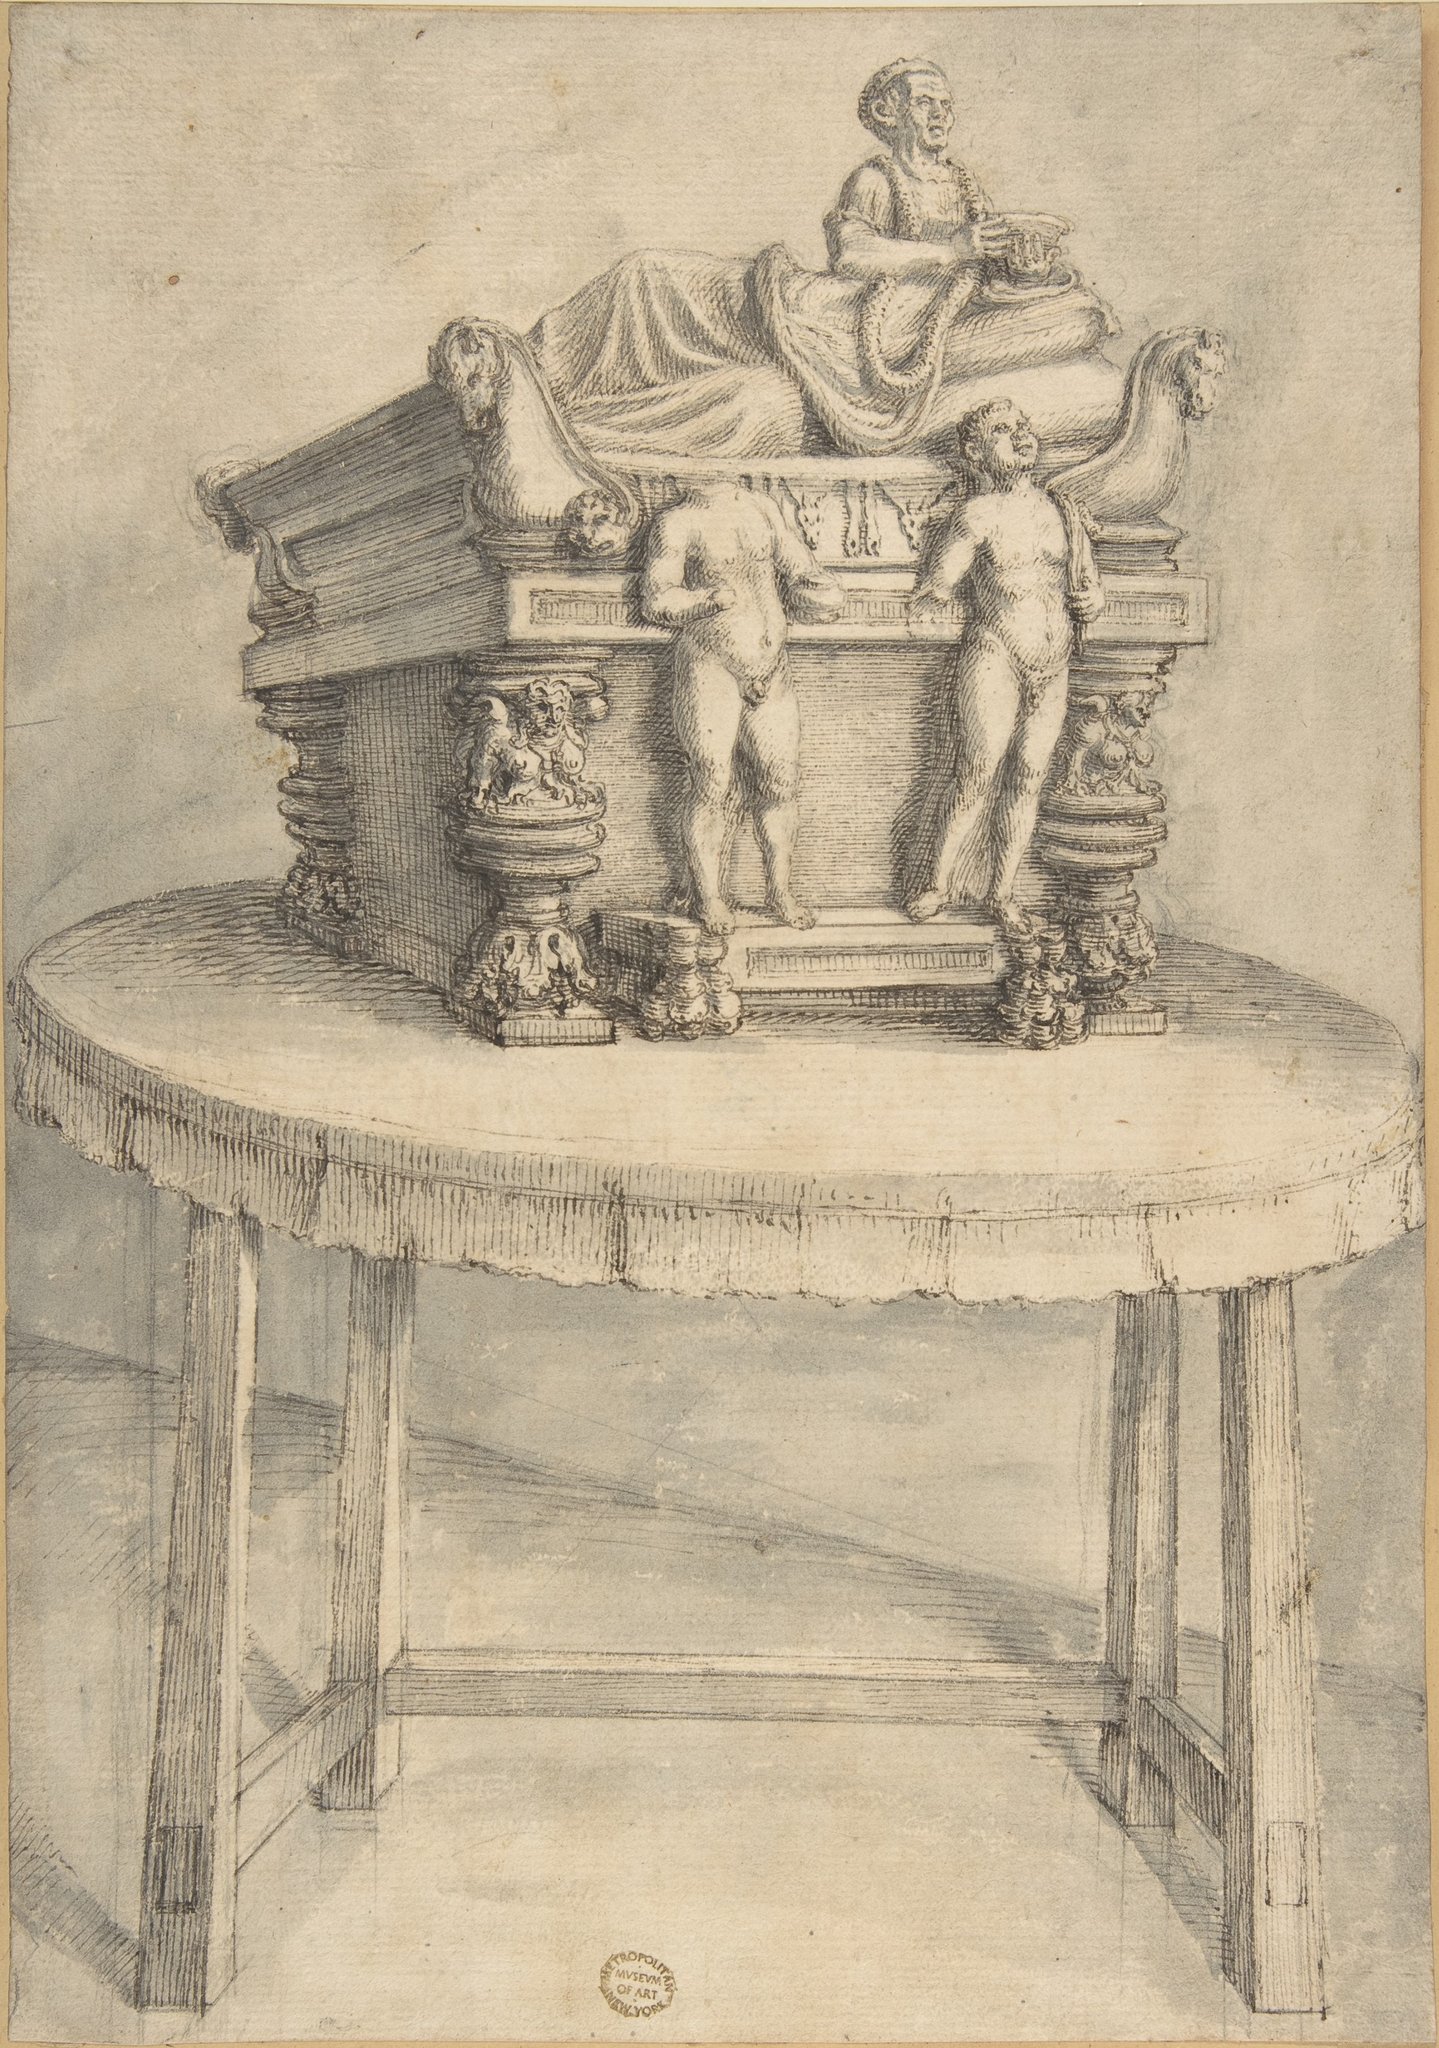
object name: collection ornament architecture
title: Sarcophagus on a table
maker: anonymous, italian, 18th century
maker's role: artist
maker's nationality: italian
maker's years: 1700-1800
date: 1701-1800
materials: ink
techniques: pen, wash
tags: men,male nudes,horses,sarcophagus,tables